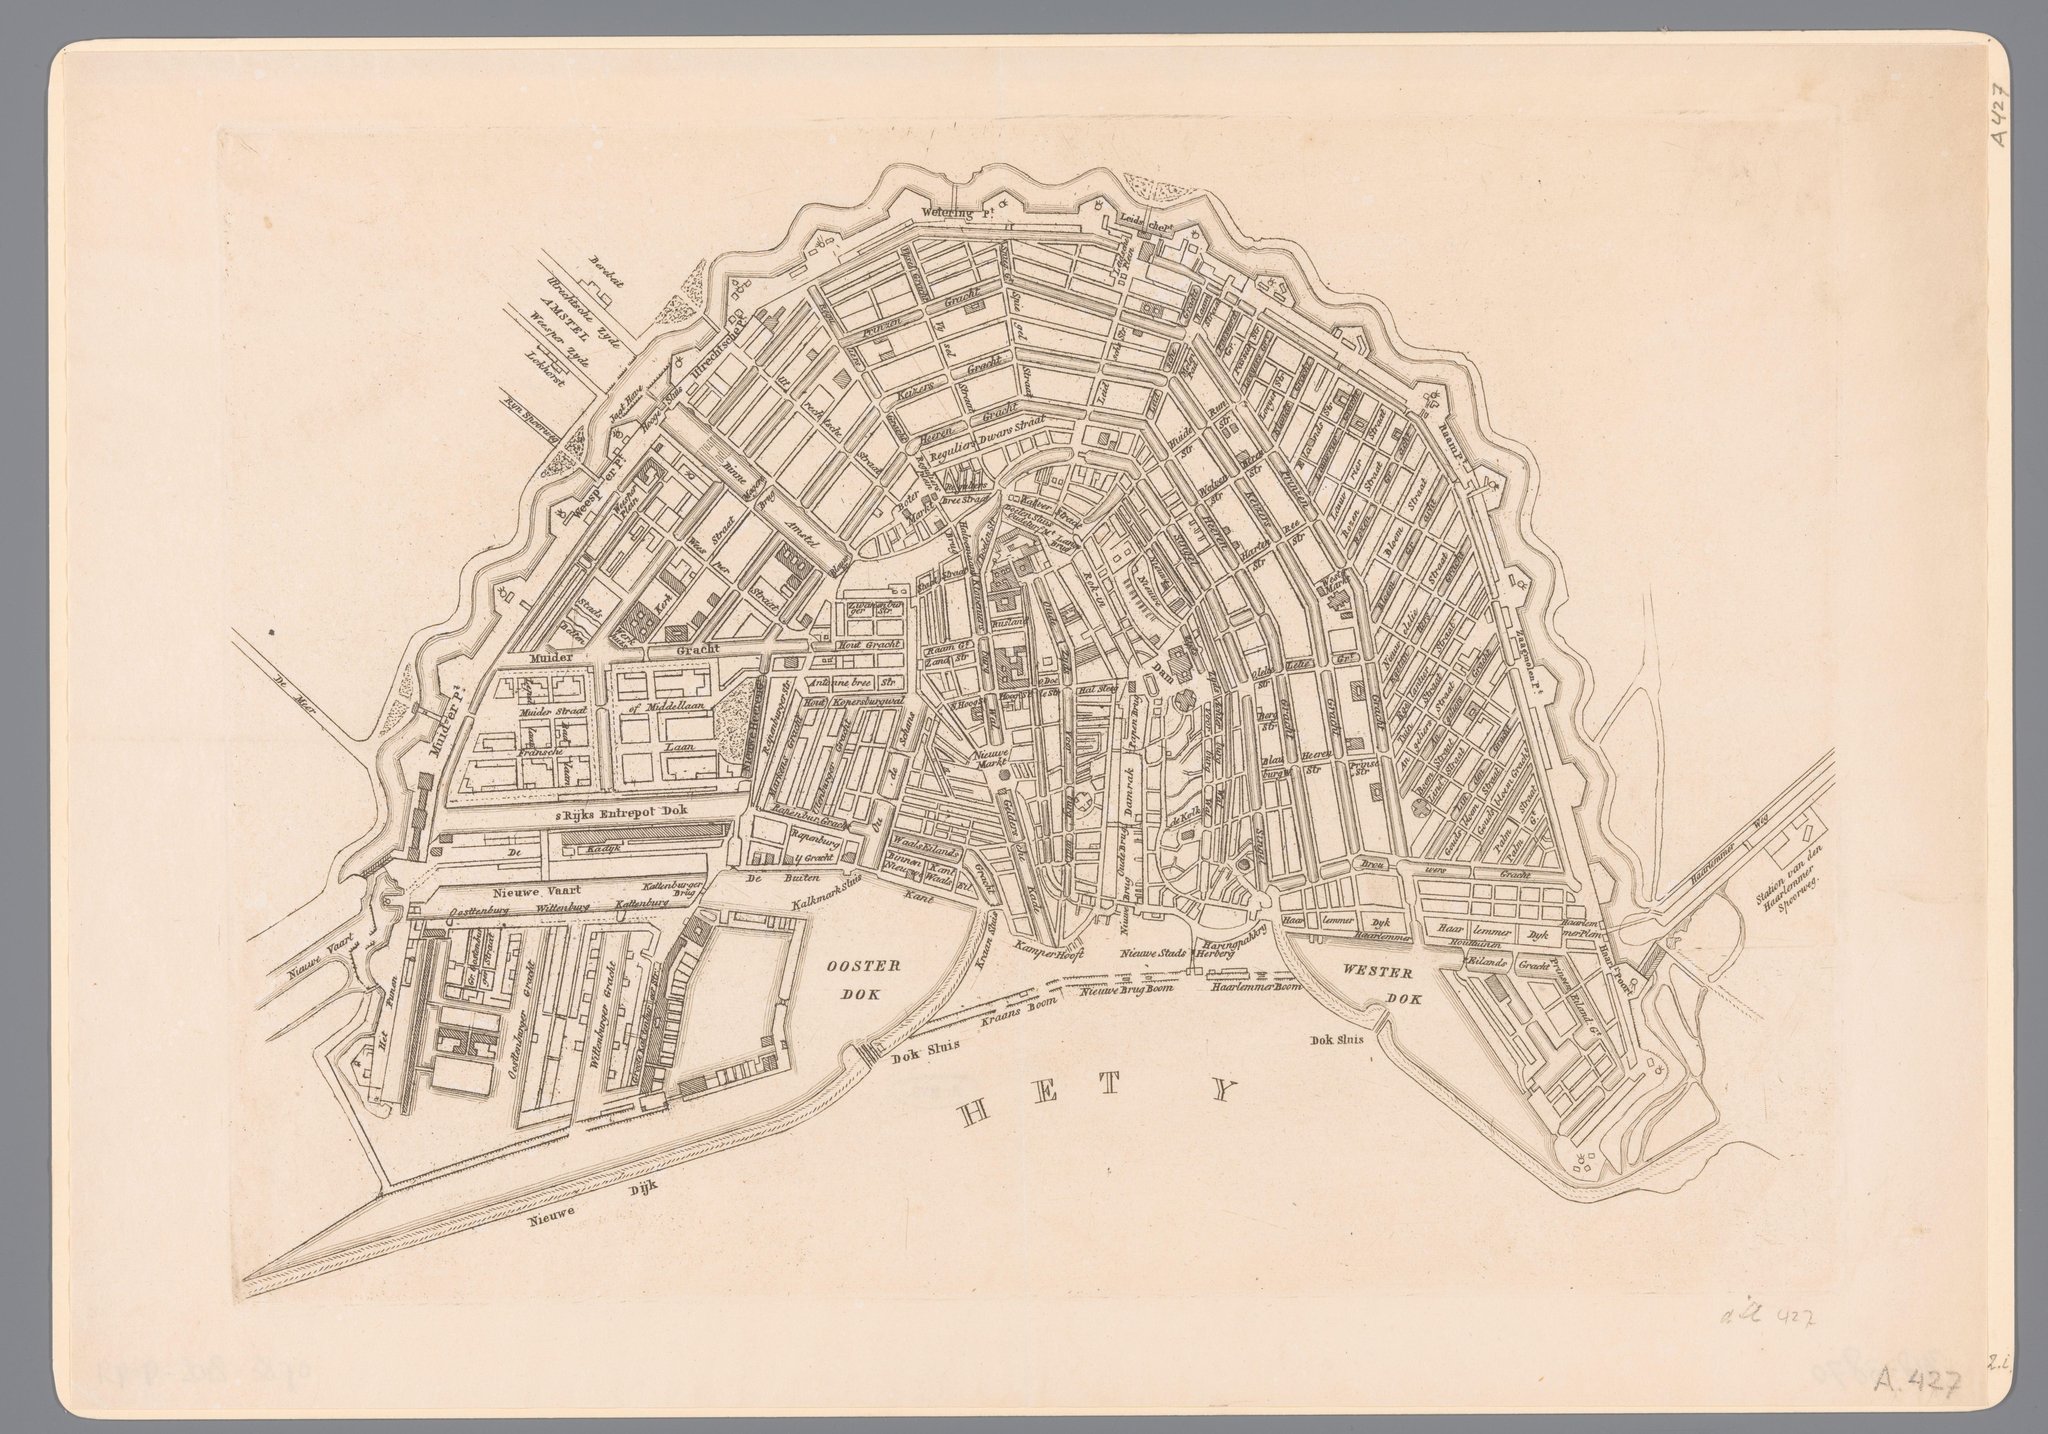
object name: area plan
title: Plattegrond van Amsterdam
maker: Anonymous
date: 1700-1750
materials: paper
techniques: etching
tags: maps of cities, amsterdam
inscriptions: collector's mark: Lugt 2228